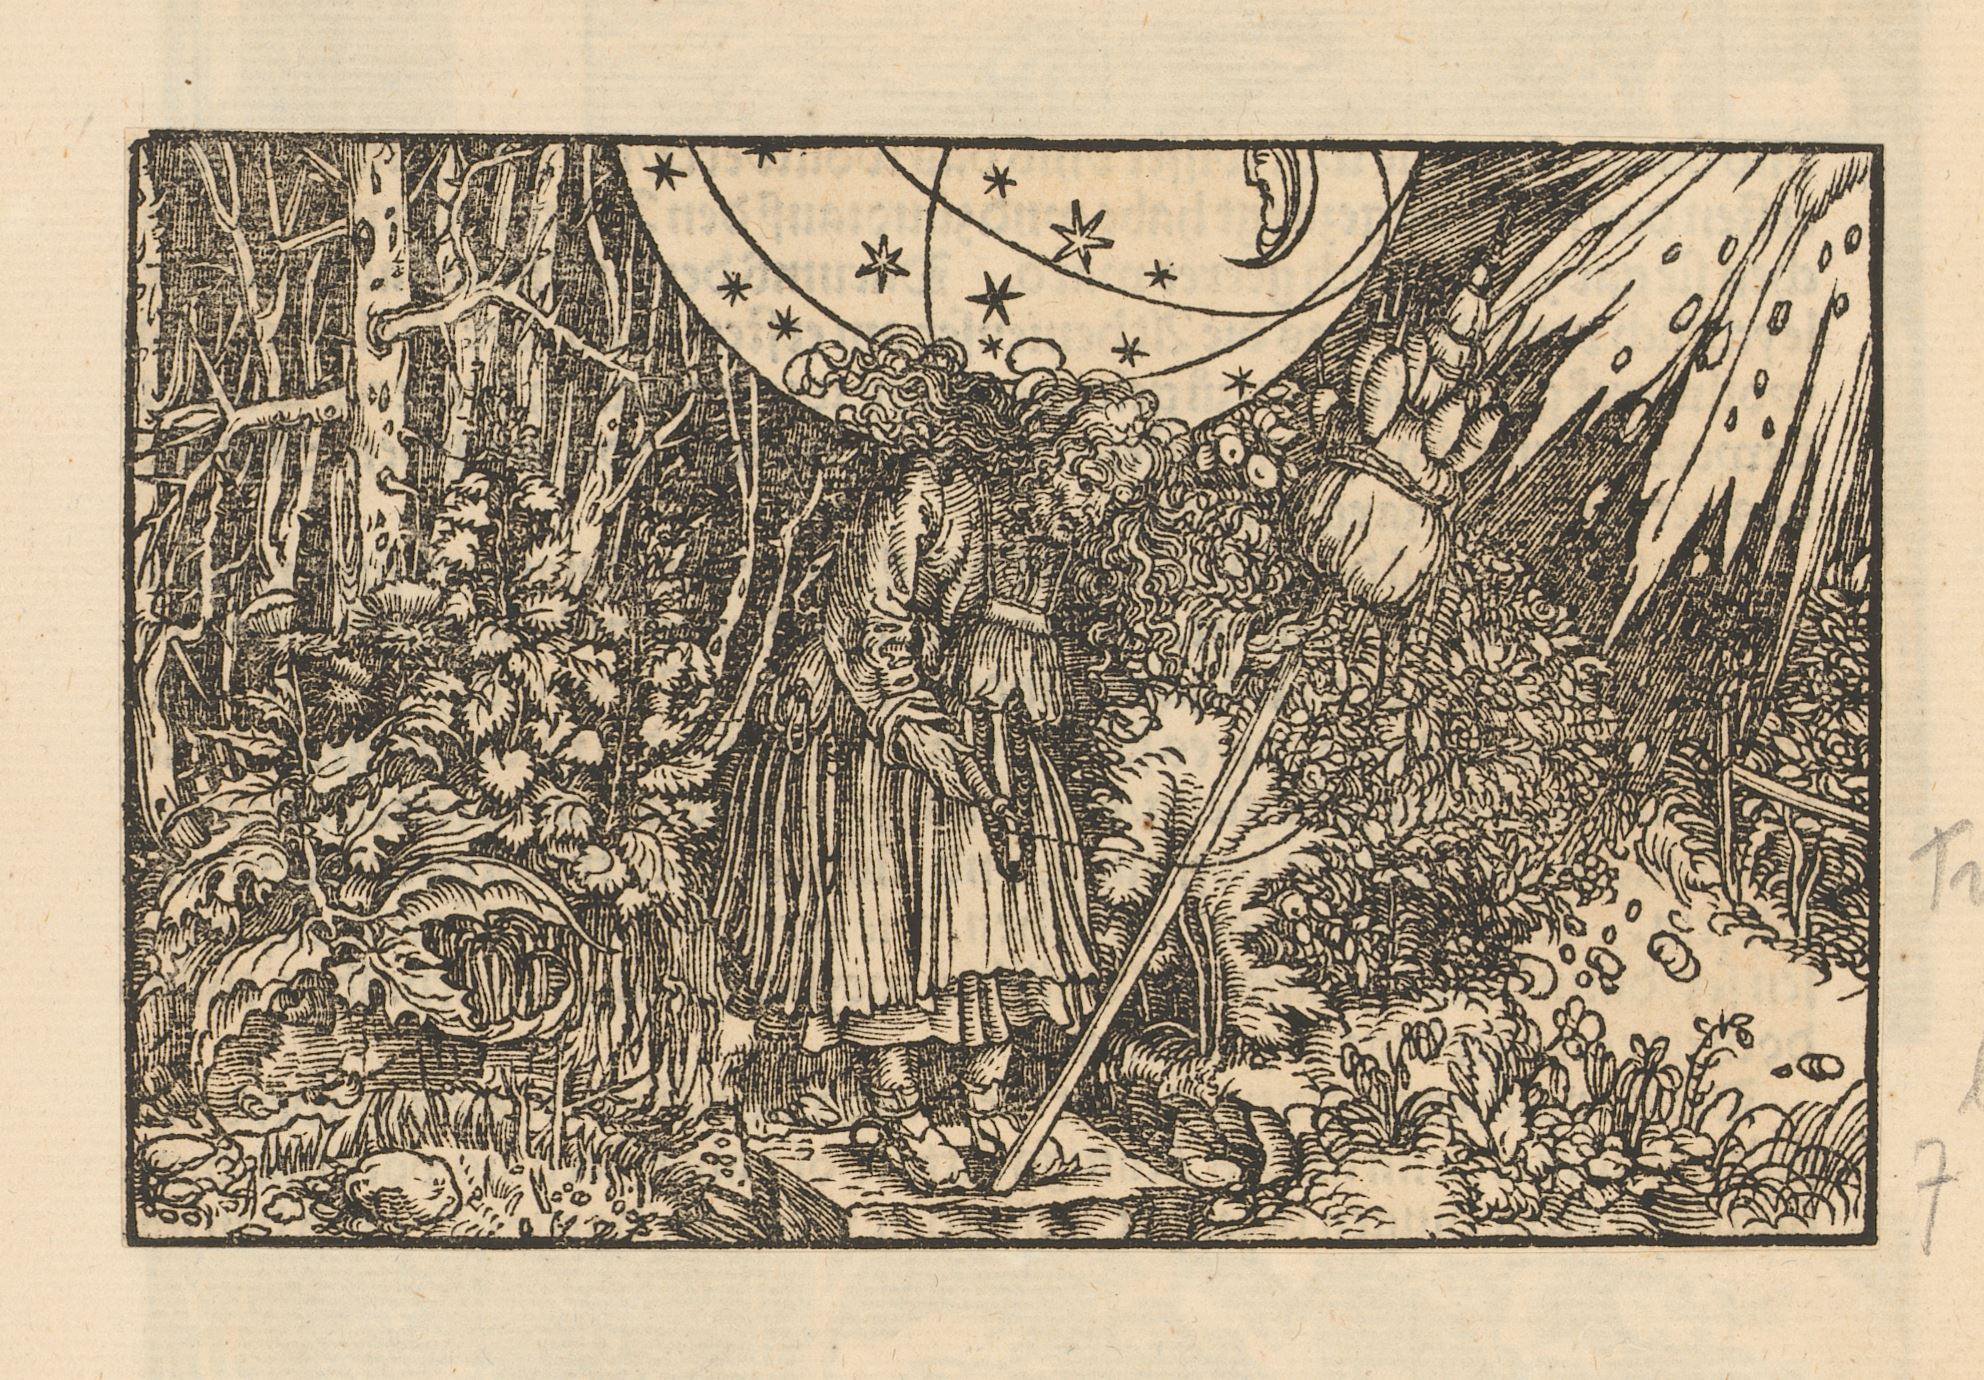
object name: print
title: Vrouw met spinrokken in een bos en een hemelgewelf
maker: Anonymous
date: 1514-1532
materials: paper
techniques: letterpress printing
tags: distaff, virtuousness; 'amor di virtù', 'attione virtuosa', 'guida sicura de' veri honori', 'virtù', 'virtù insuperabile' (ripa), firmament, sky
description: Deze prent is gebruikt in: Petrarca, Francesco. Von der Artzney bayder Glück, des guten und widerwertigen: unnd weß sich ain yeder inn Gelück und Unglück halten sol (...). Augsburg: Heinrich Steiner, 1532. Deze uitgave is ook bekend onder de titel 'Trostspiegel in Glück und Unglück'.